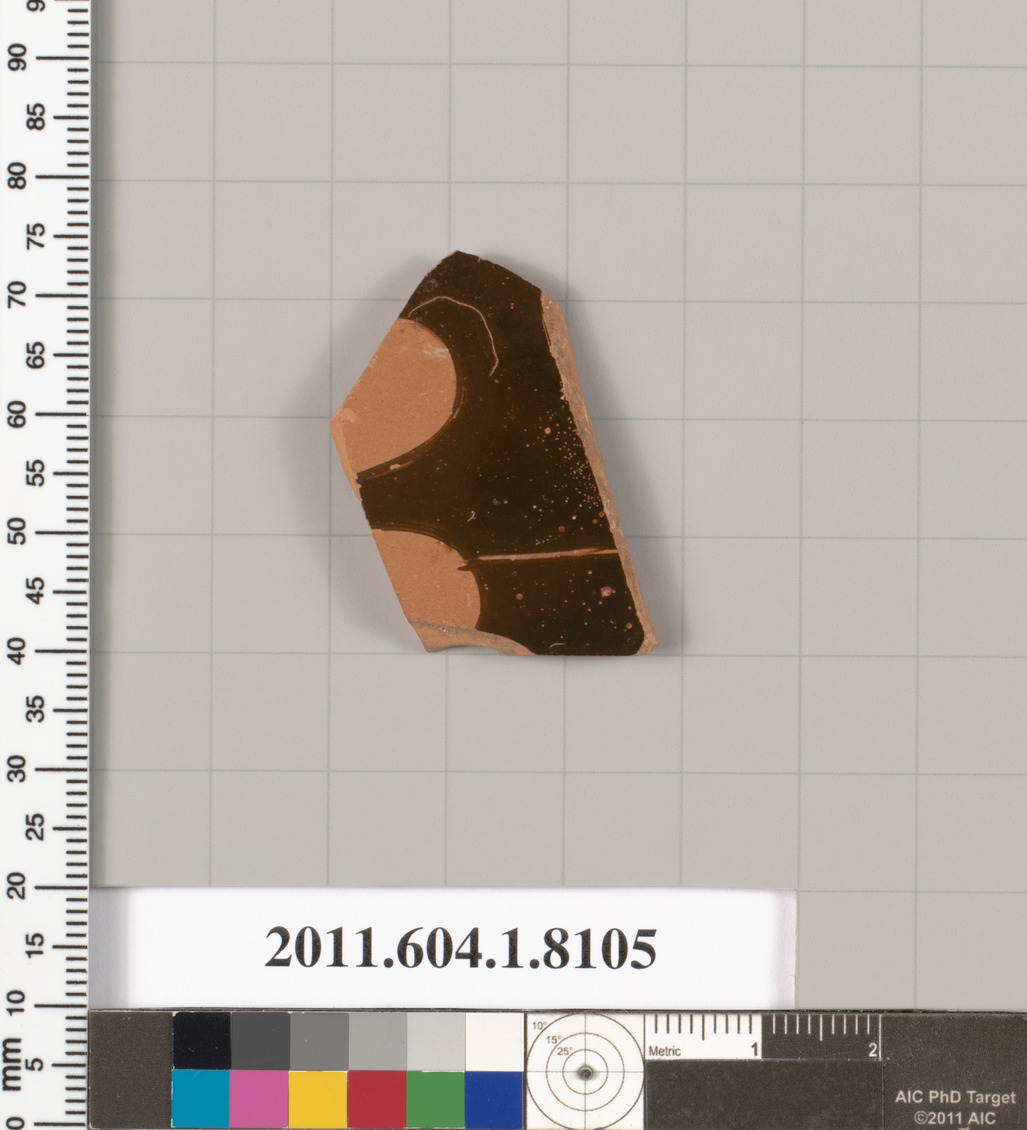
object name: kylix fragment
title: Terracotta fragment of a kylix (drinking cup)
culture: greek, attic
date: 520-510 BCE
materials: terracotta